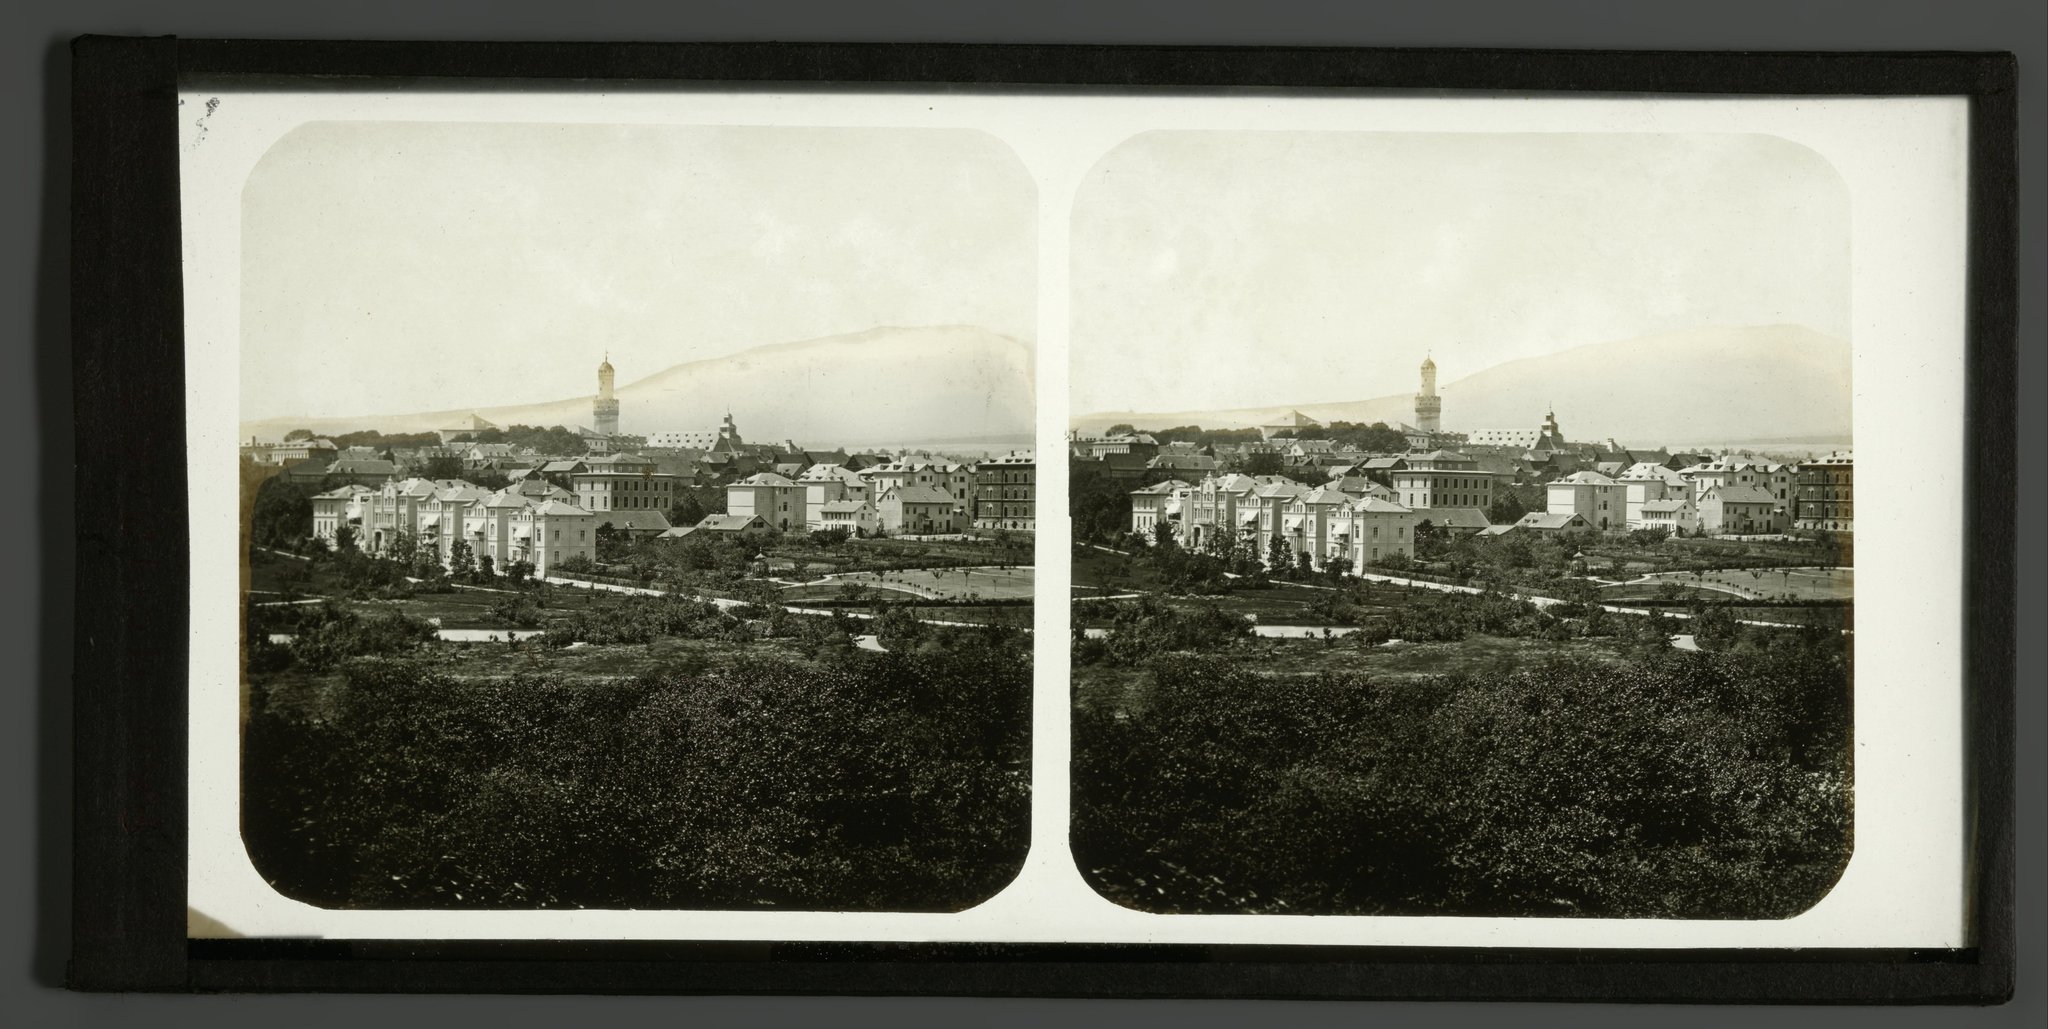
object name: photograph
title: Stadsgezicht in Duitsland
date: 1860-1890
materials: glass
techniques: slide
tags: city-view in general; 'veduta', germany